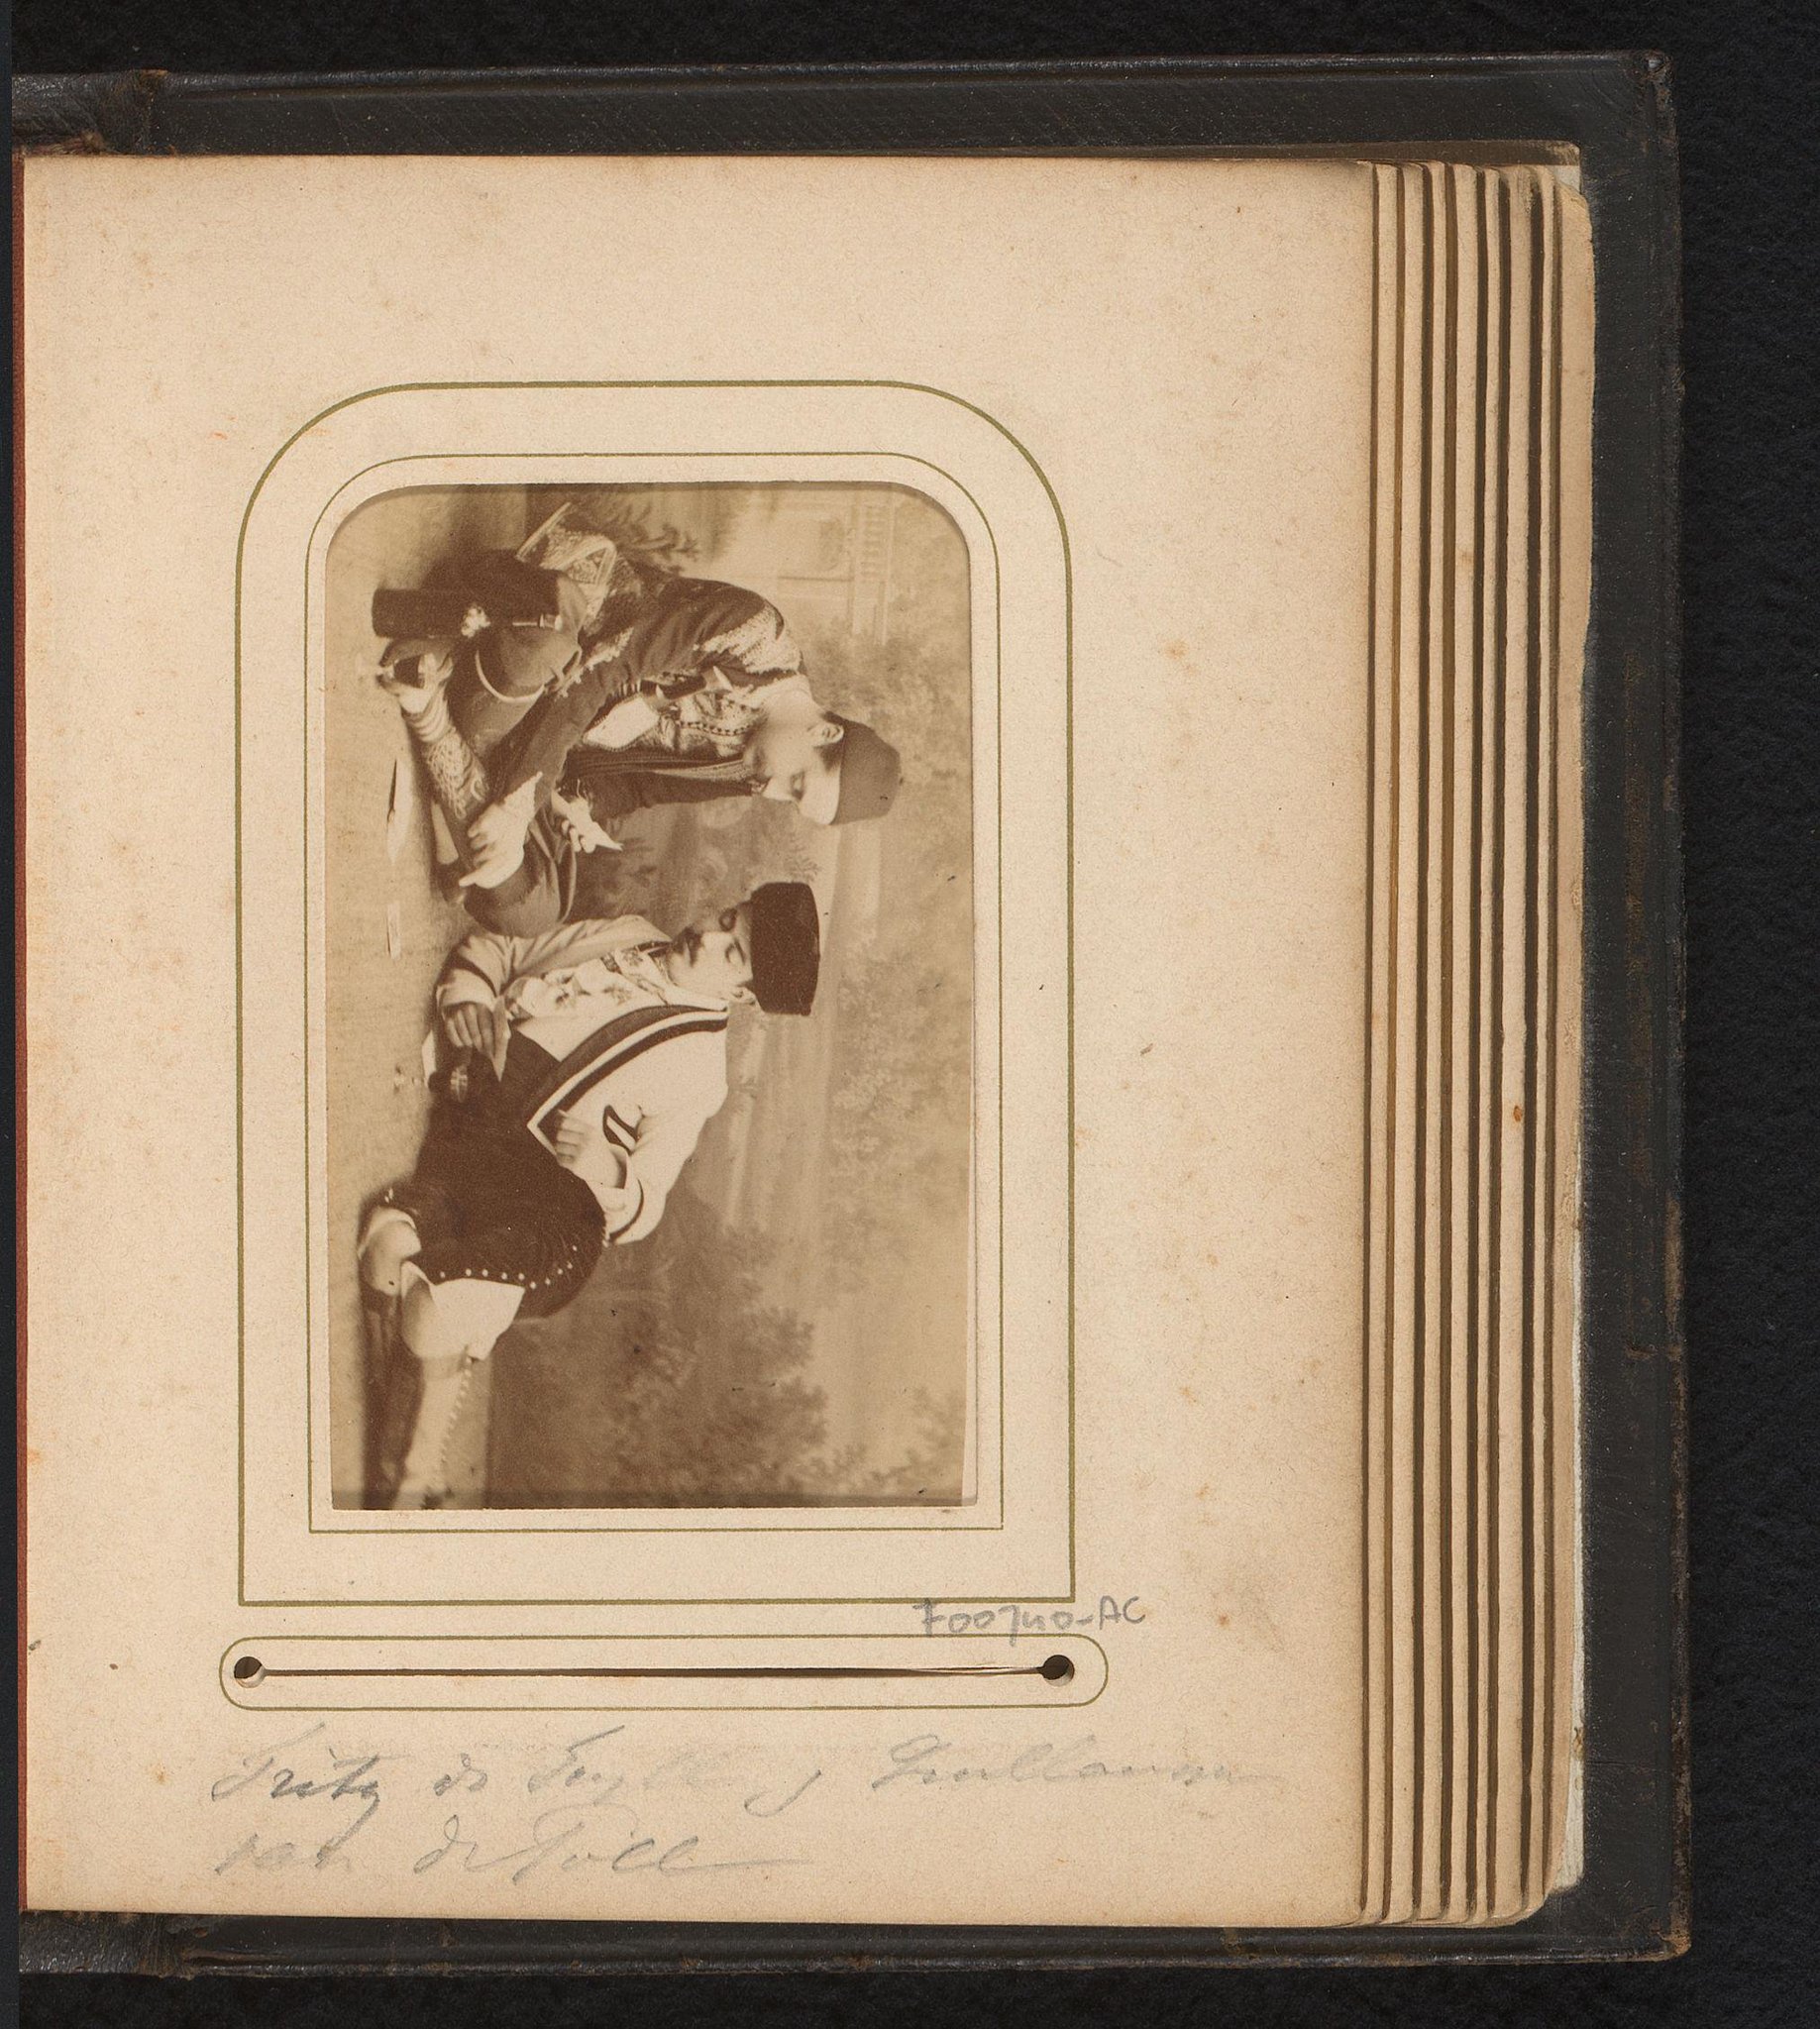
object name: album leaf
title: Portret van twee mannen, Fritz de Tuyll en meneer de Poll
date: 1877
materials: cardboard, photographic support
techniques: albumen print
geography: the hague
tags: historical persons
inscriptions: inscription: ‘De Lavieter & Co./ Photographes/ Willemstraat No2/ La Haye’